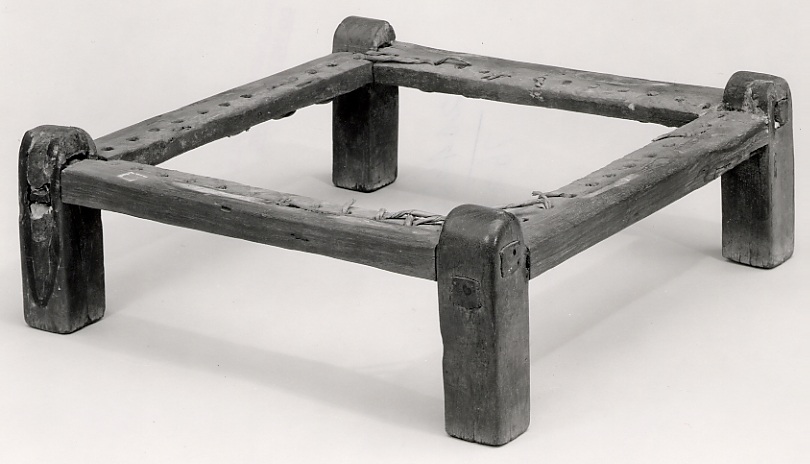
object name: stool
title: Low stool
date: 1981-1802 BCE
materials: wood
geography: egypt